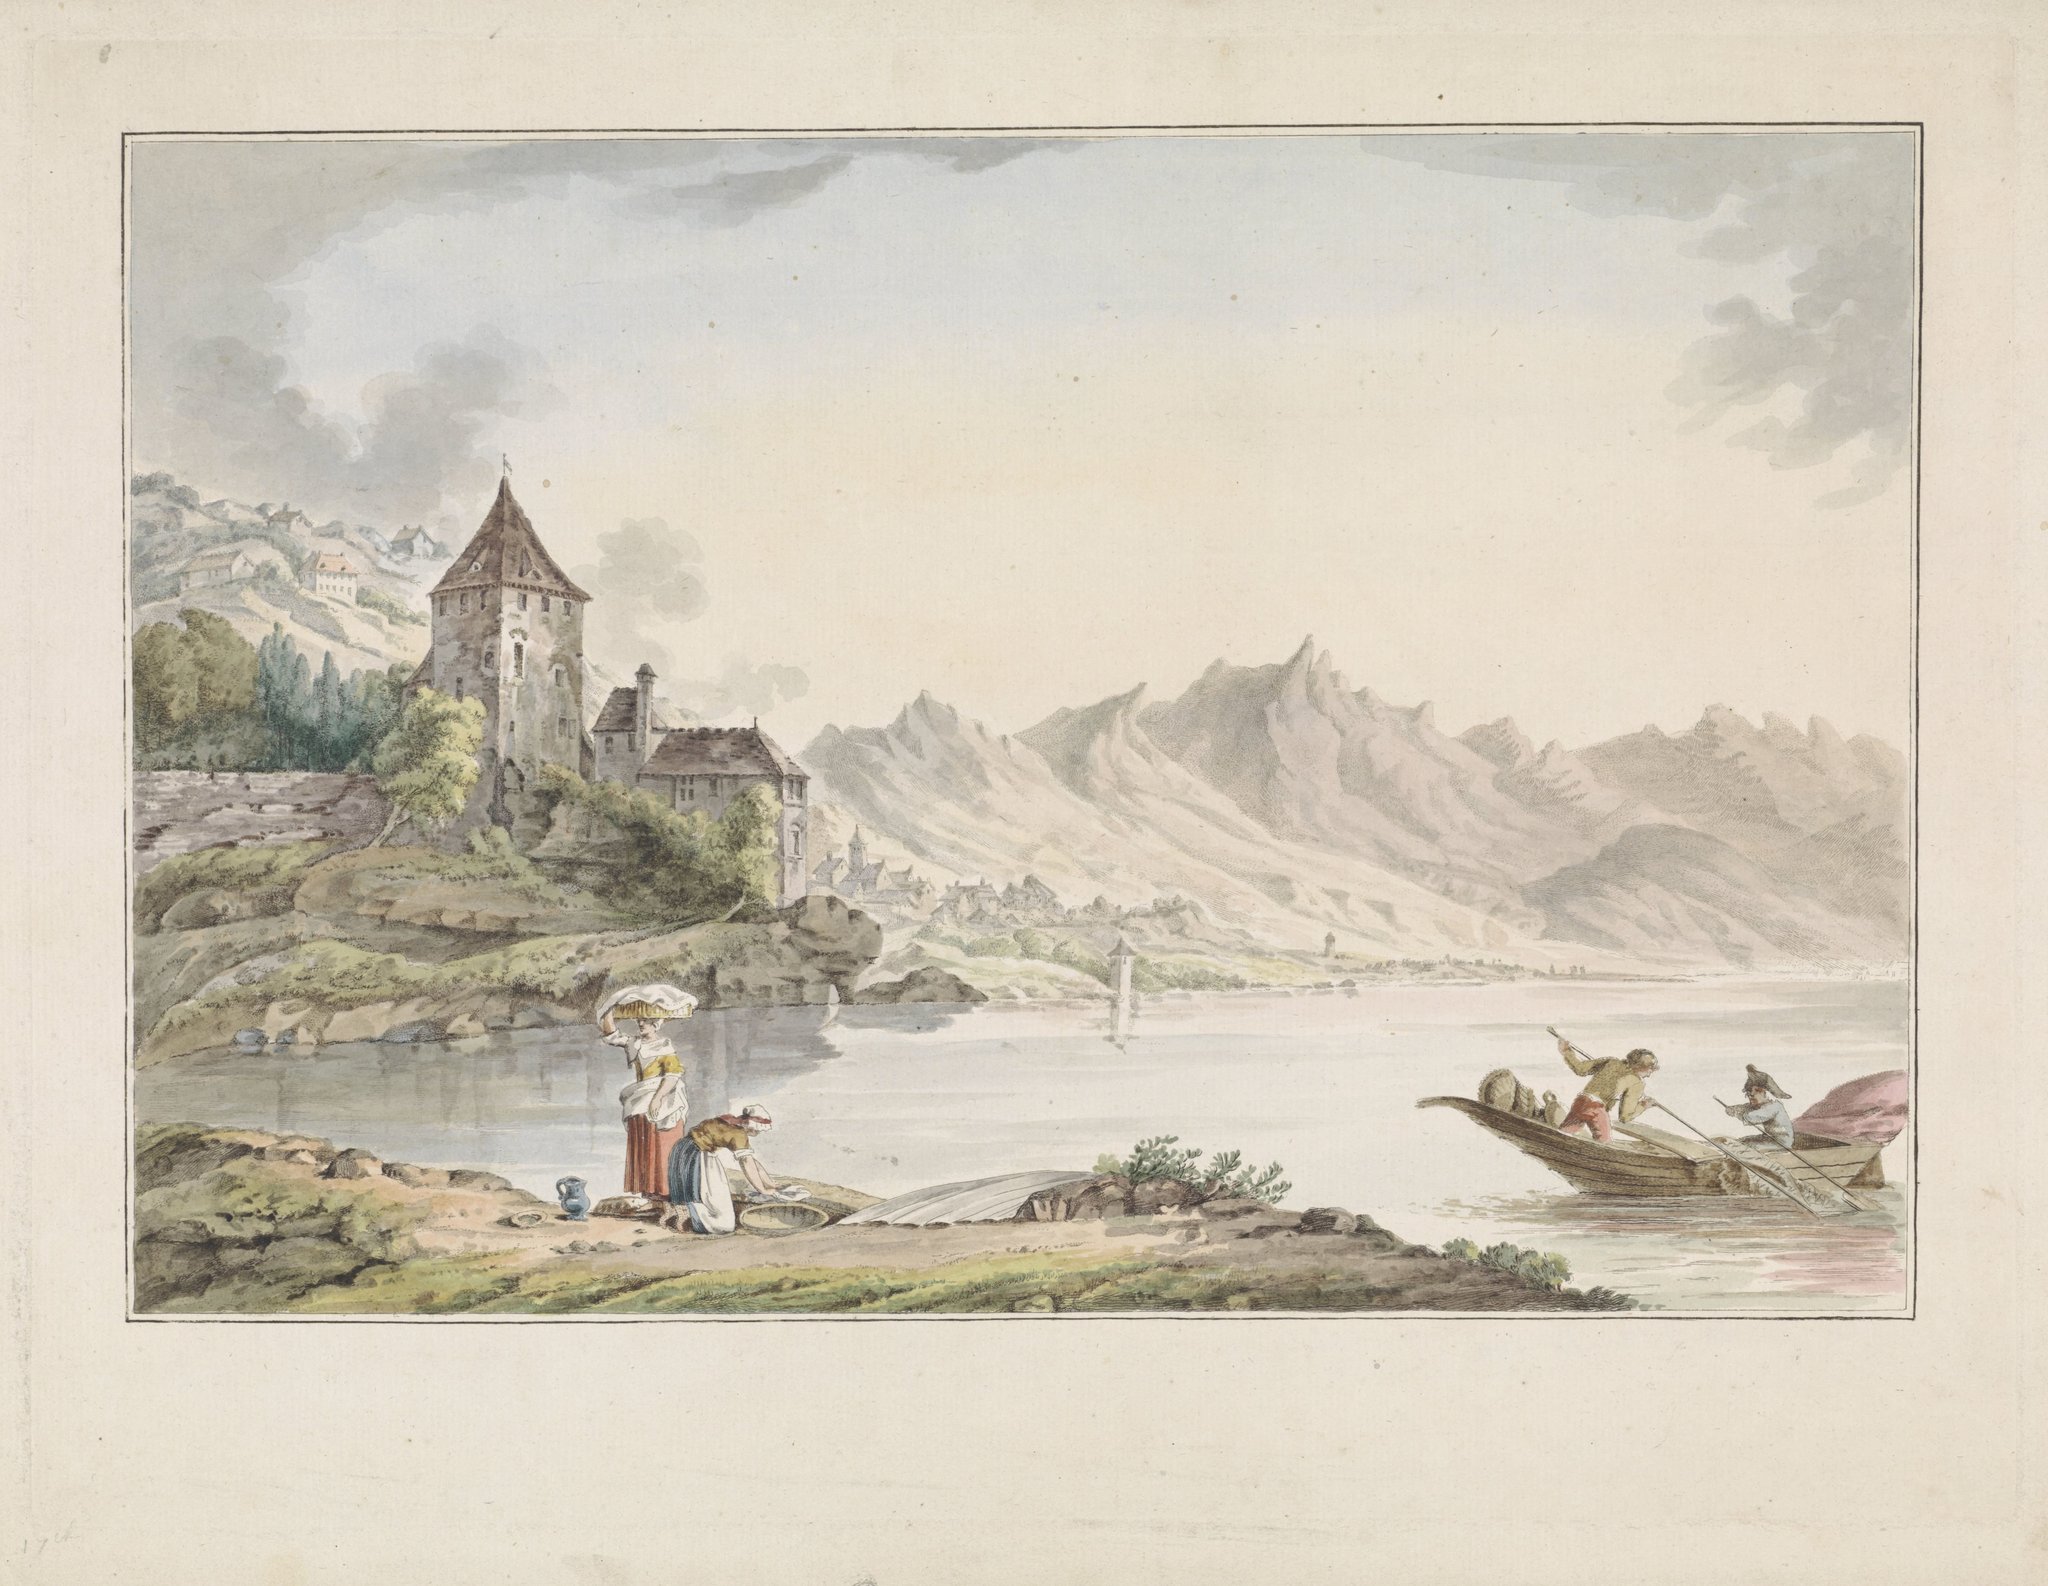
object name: print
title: Gezicht op een kerk aan een meer te Zwitserland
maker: jan gerard waldorp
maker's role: draughtsman, print maker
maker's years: 1740-1808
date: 1792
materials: paper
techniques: etching, hand coloring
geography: amsterdam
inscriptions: collector's mark: Lugt 2228